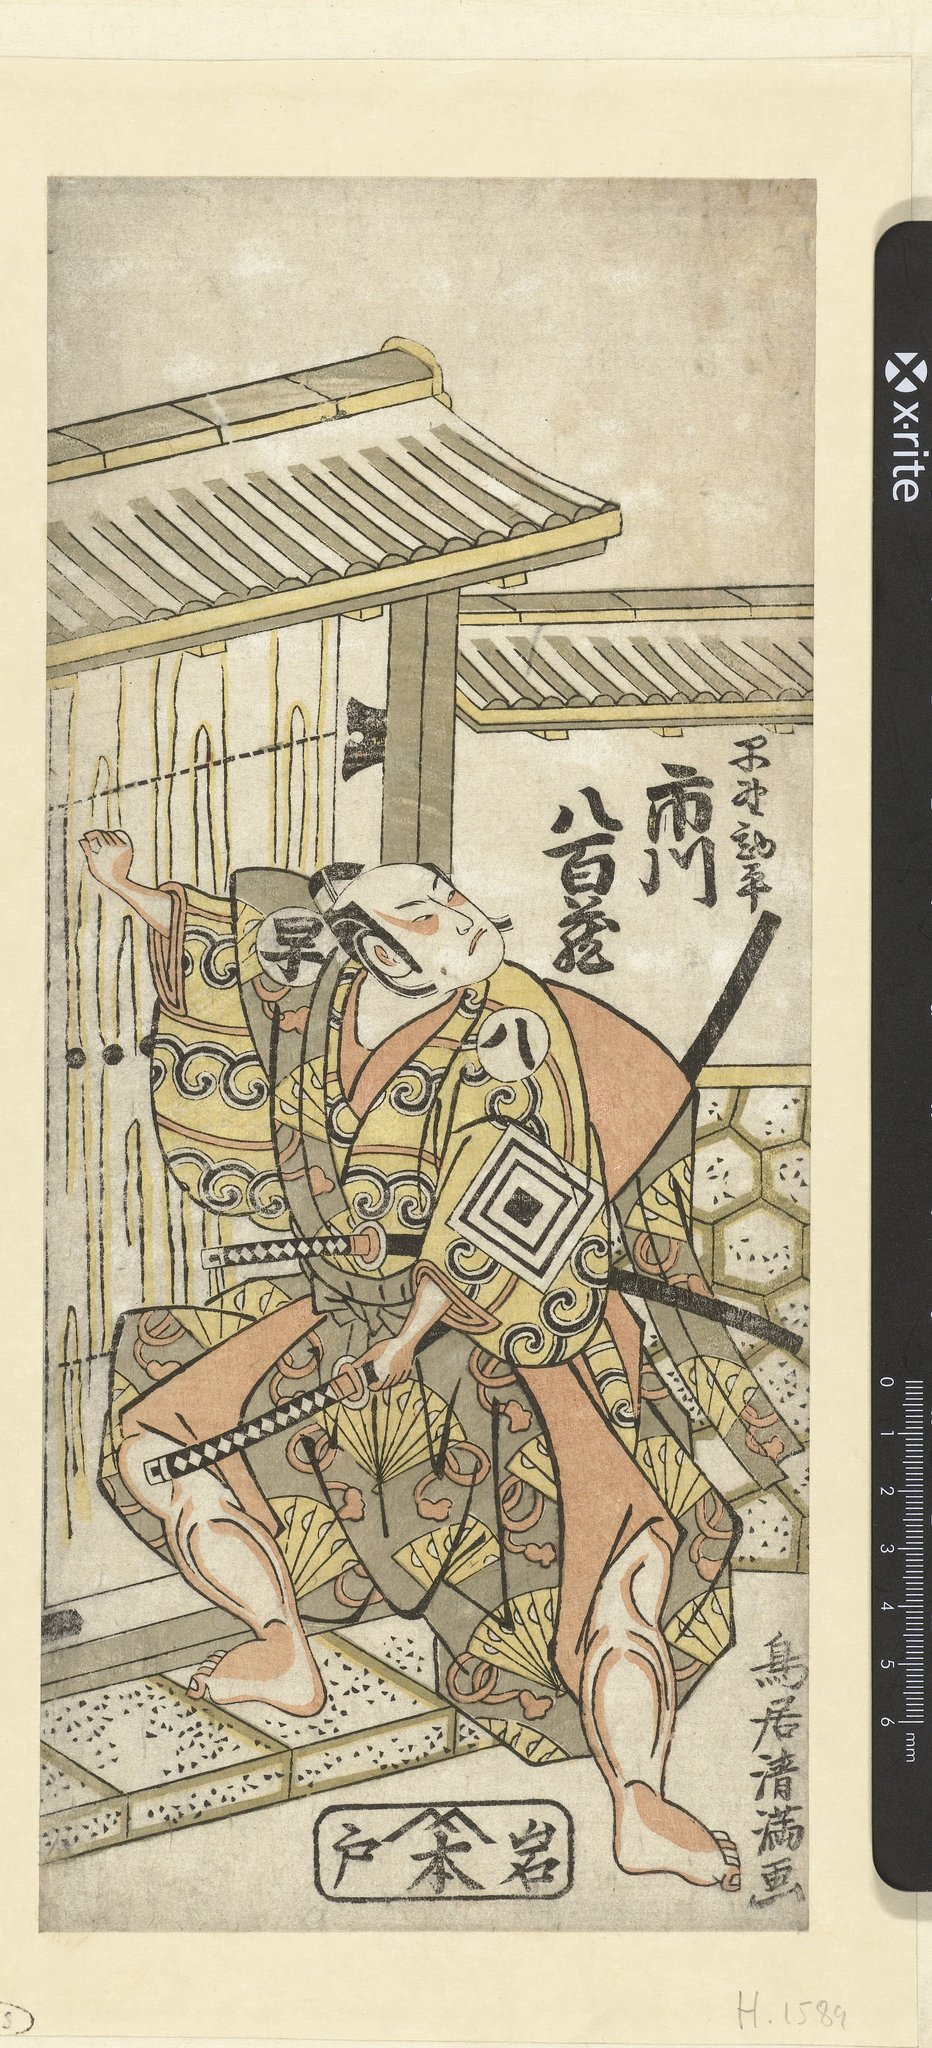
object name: print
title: Actor at a Gate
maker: torii kiyomitsu (i)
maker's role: print maker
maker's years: 1735-1785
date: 1755-1760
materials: paper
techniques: woodcut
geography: tokyo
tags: hacking and thrusting weapons: sword, gate, entrance, portrait of actor, actress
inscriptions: collector's mark: Lugt 2228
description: Colour woodblock printing advanced swiftly in the mid-18th century. This print depicts a scene from a play. In addition to the black line block, three colour blocks were used: red, yellow, and purple. The natural pigments used are very sensitive to daylight. Consequently, the purple has turned grey and the once vibrant red and green colours have faded.